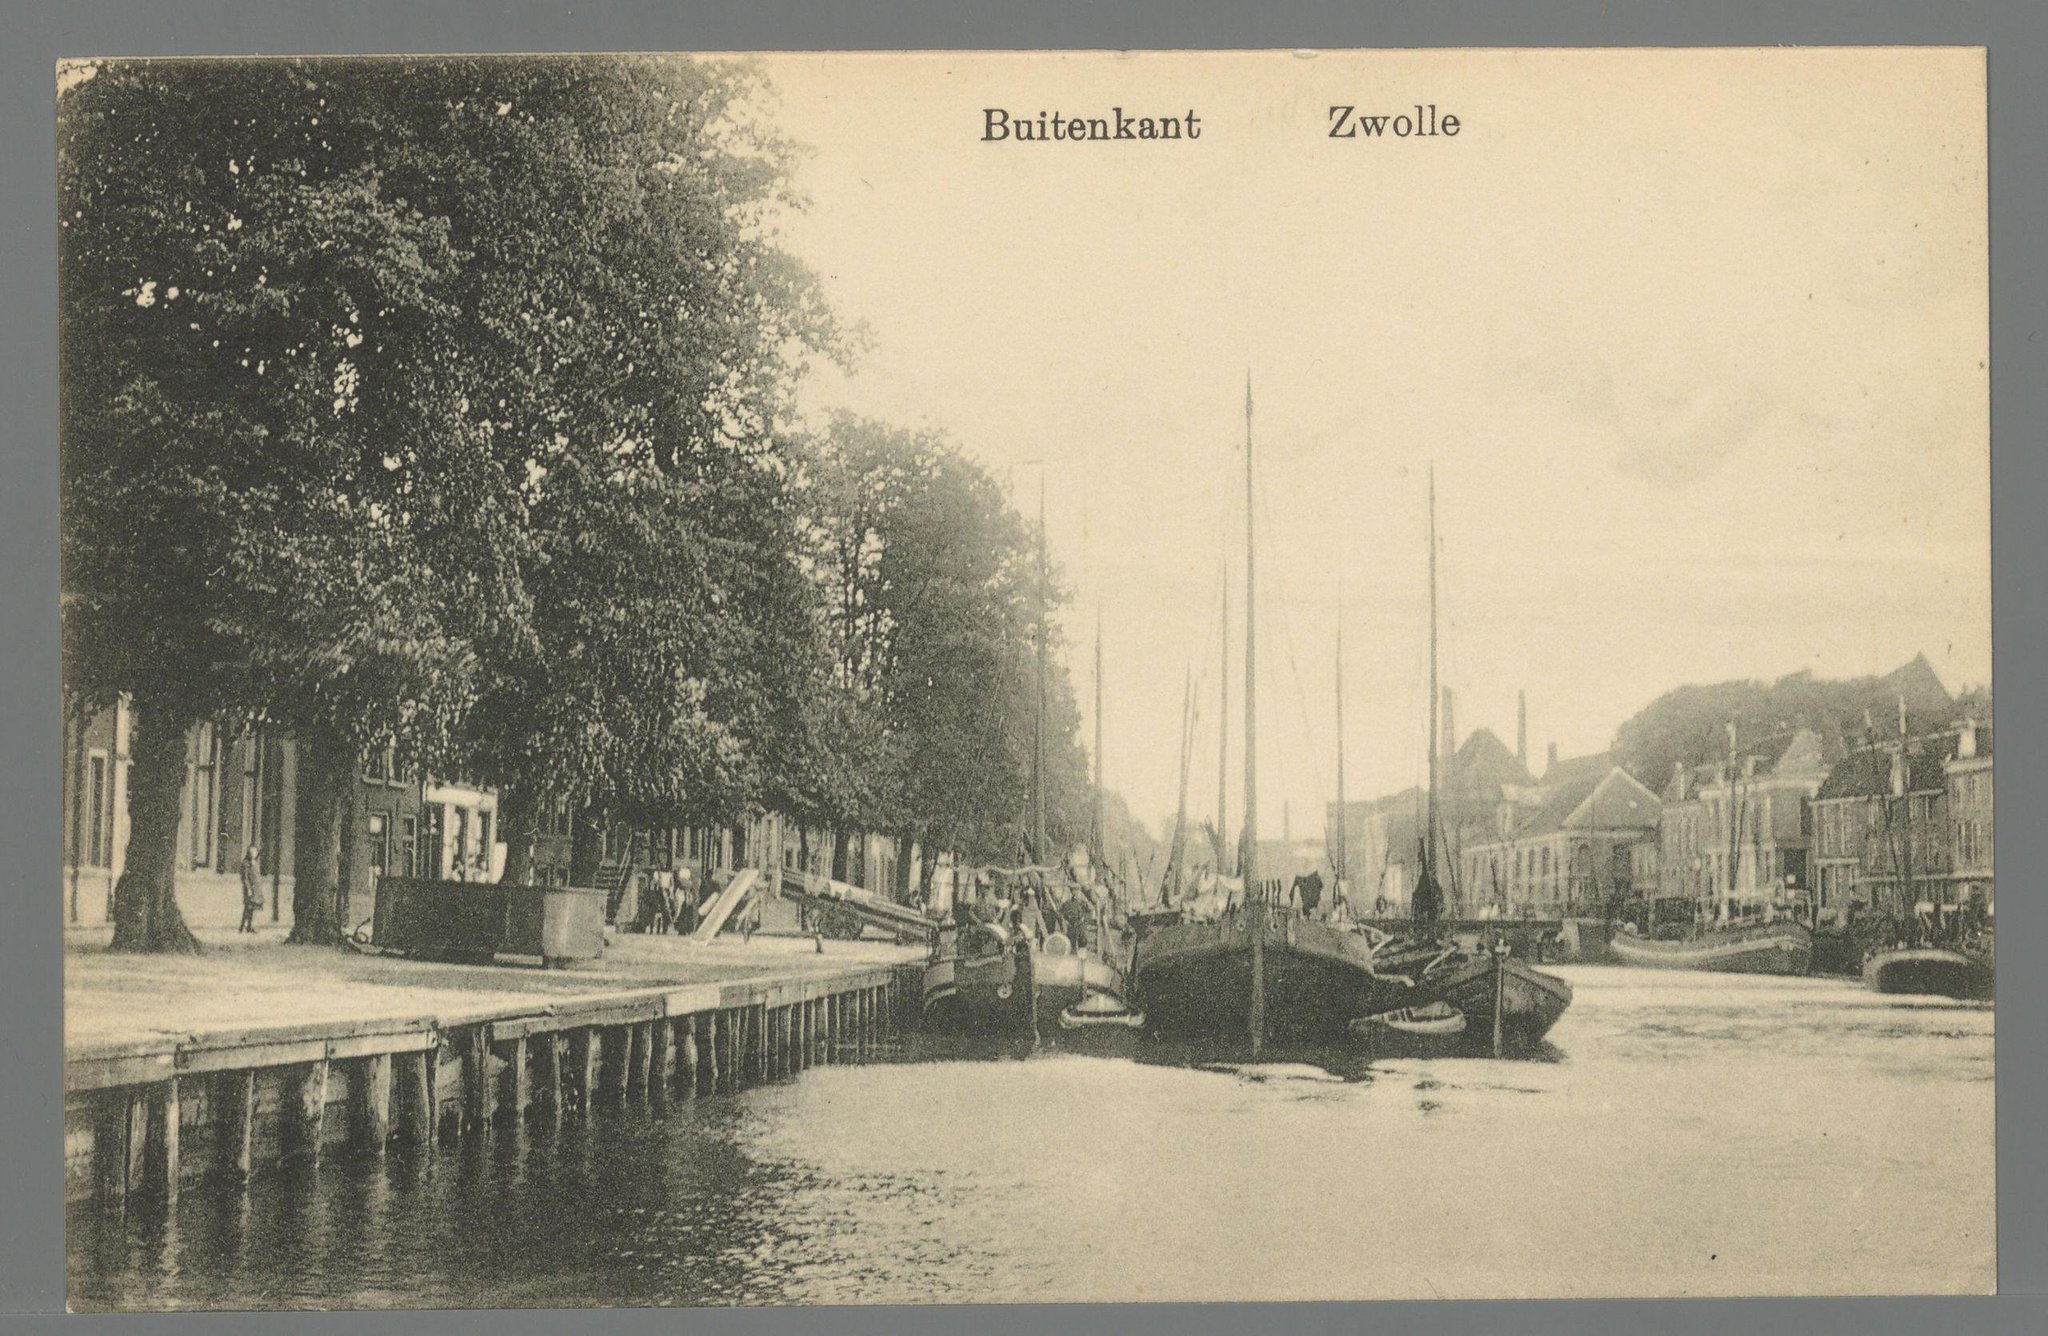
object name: ansichtkaart, prentbriefkaart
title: Buitenkant. Zwolle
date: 1905-1930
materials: cardboard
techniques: photograph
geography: zwolle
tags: sailing-ship, sailing-boat, canals, waters (in village), street